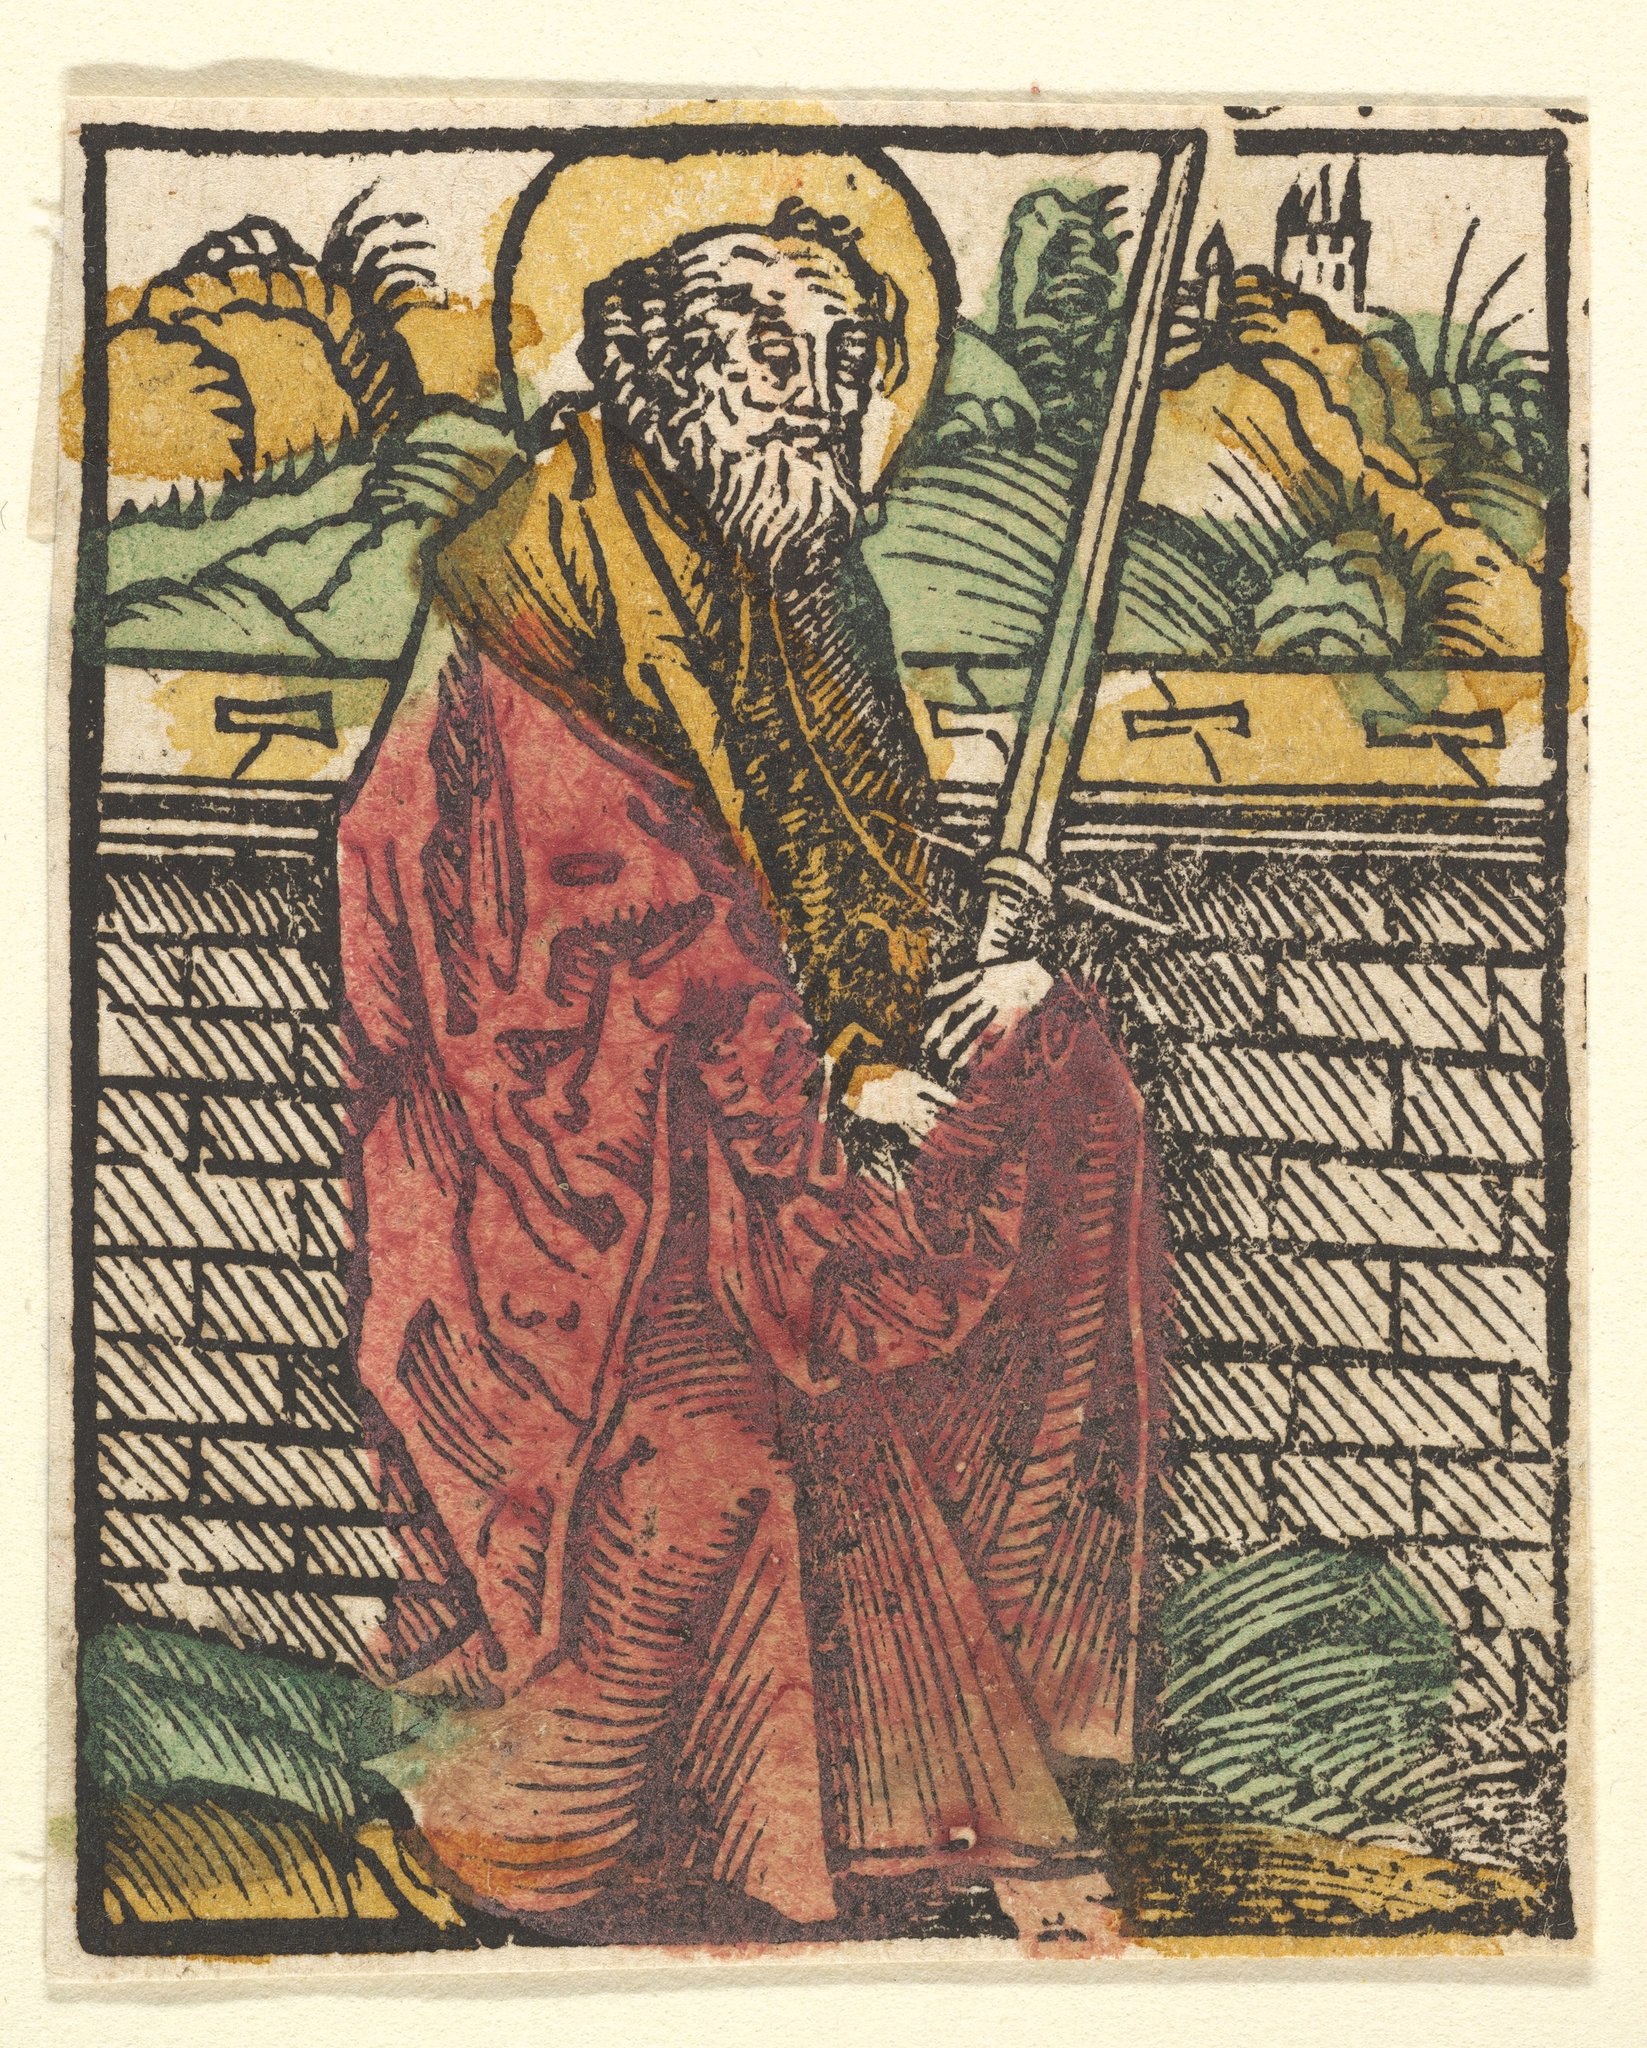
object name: print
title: St. Paul (adaptation)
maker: hans baldung (called hans baldung grien)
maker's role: artist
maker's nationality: german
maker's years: 1484-1545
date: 1512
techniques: hand coloring, woodcut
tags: saint paul